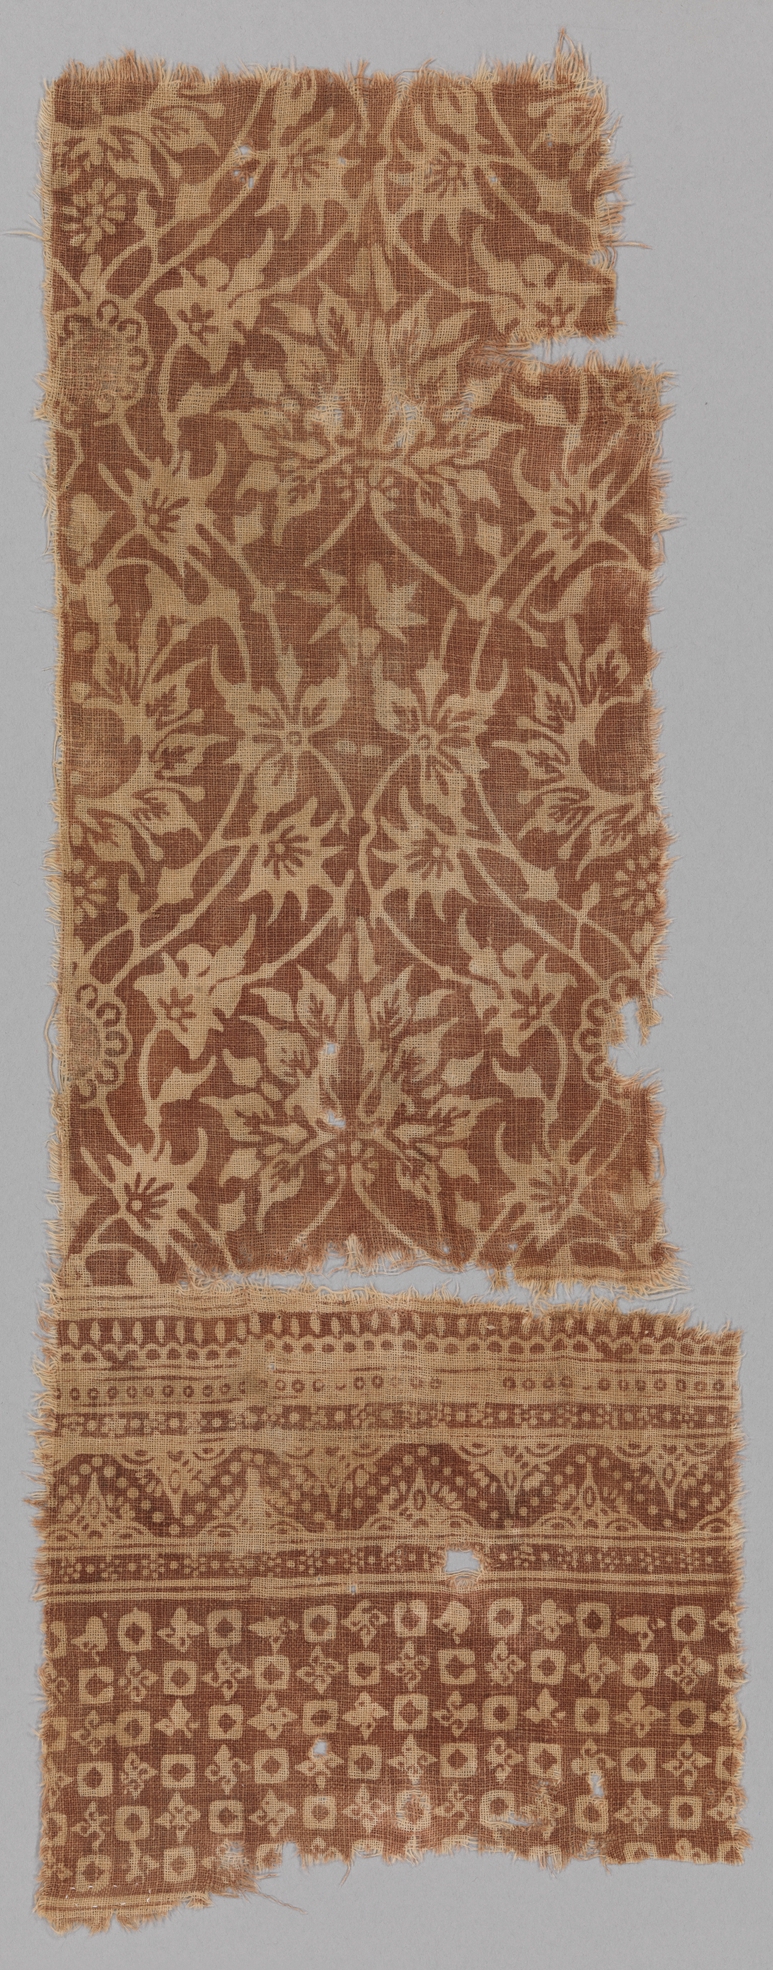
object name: textile fragment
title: Textile with Lotus and Arabesque Design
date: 1401-1500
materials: cotton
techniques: dyeing, weave, printing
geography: egypt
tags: flowers,leaves